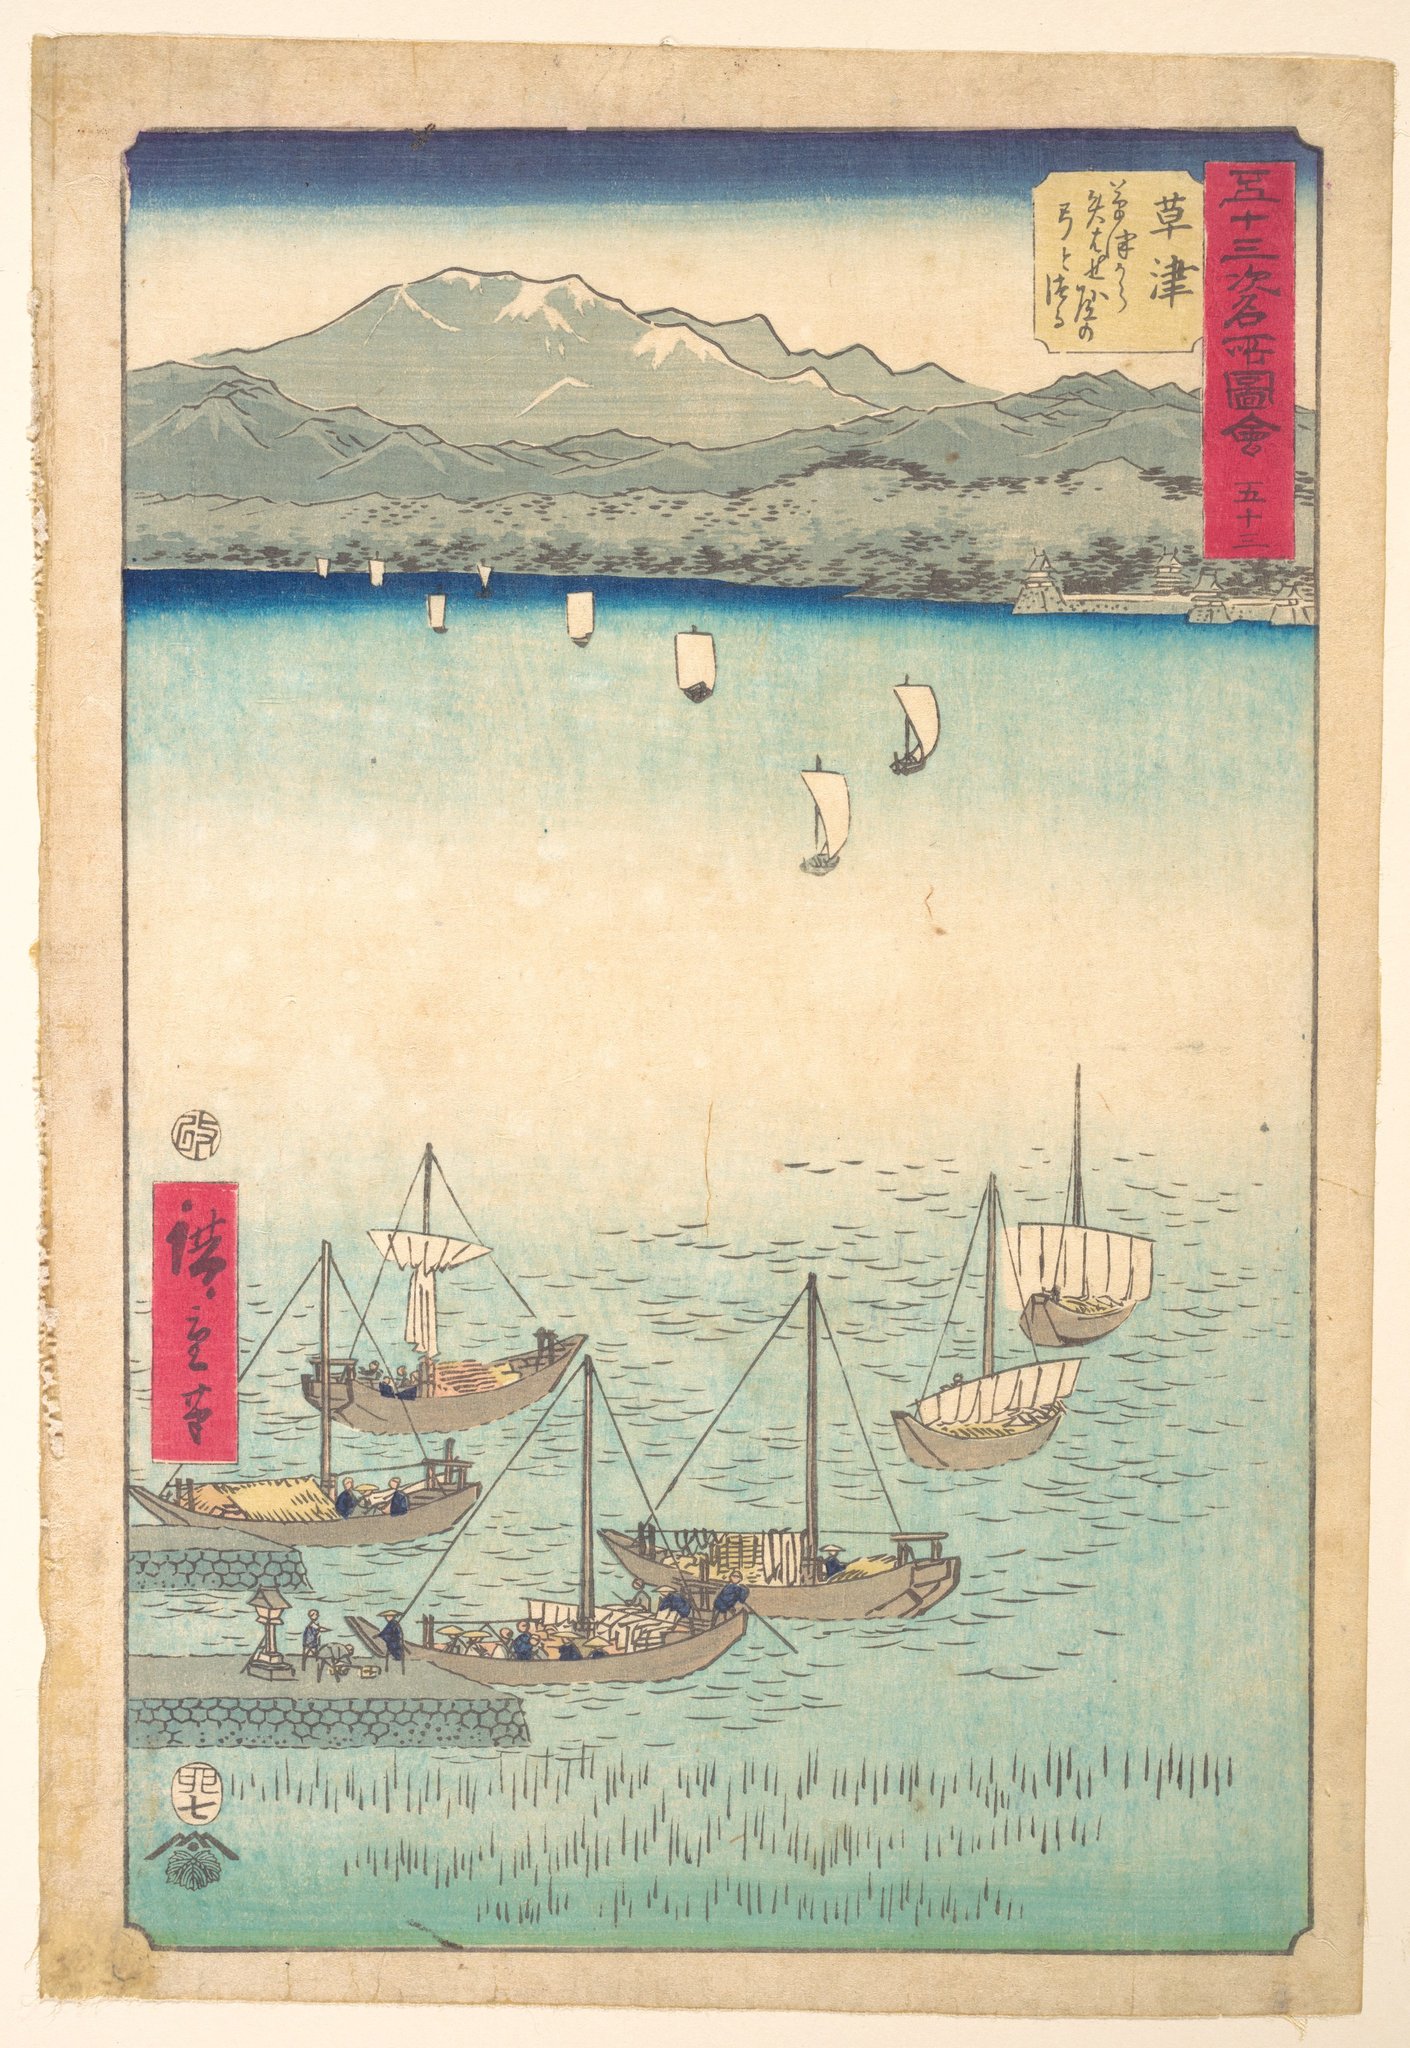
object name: print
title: Kusatsu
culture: japanese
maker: utagawa hiroshige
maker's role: artist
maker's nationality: japanese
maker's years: 1797-1858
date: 1855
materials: ink, paper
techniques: woodblock print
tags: mountains,seascapes,boats